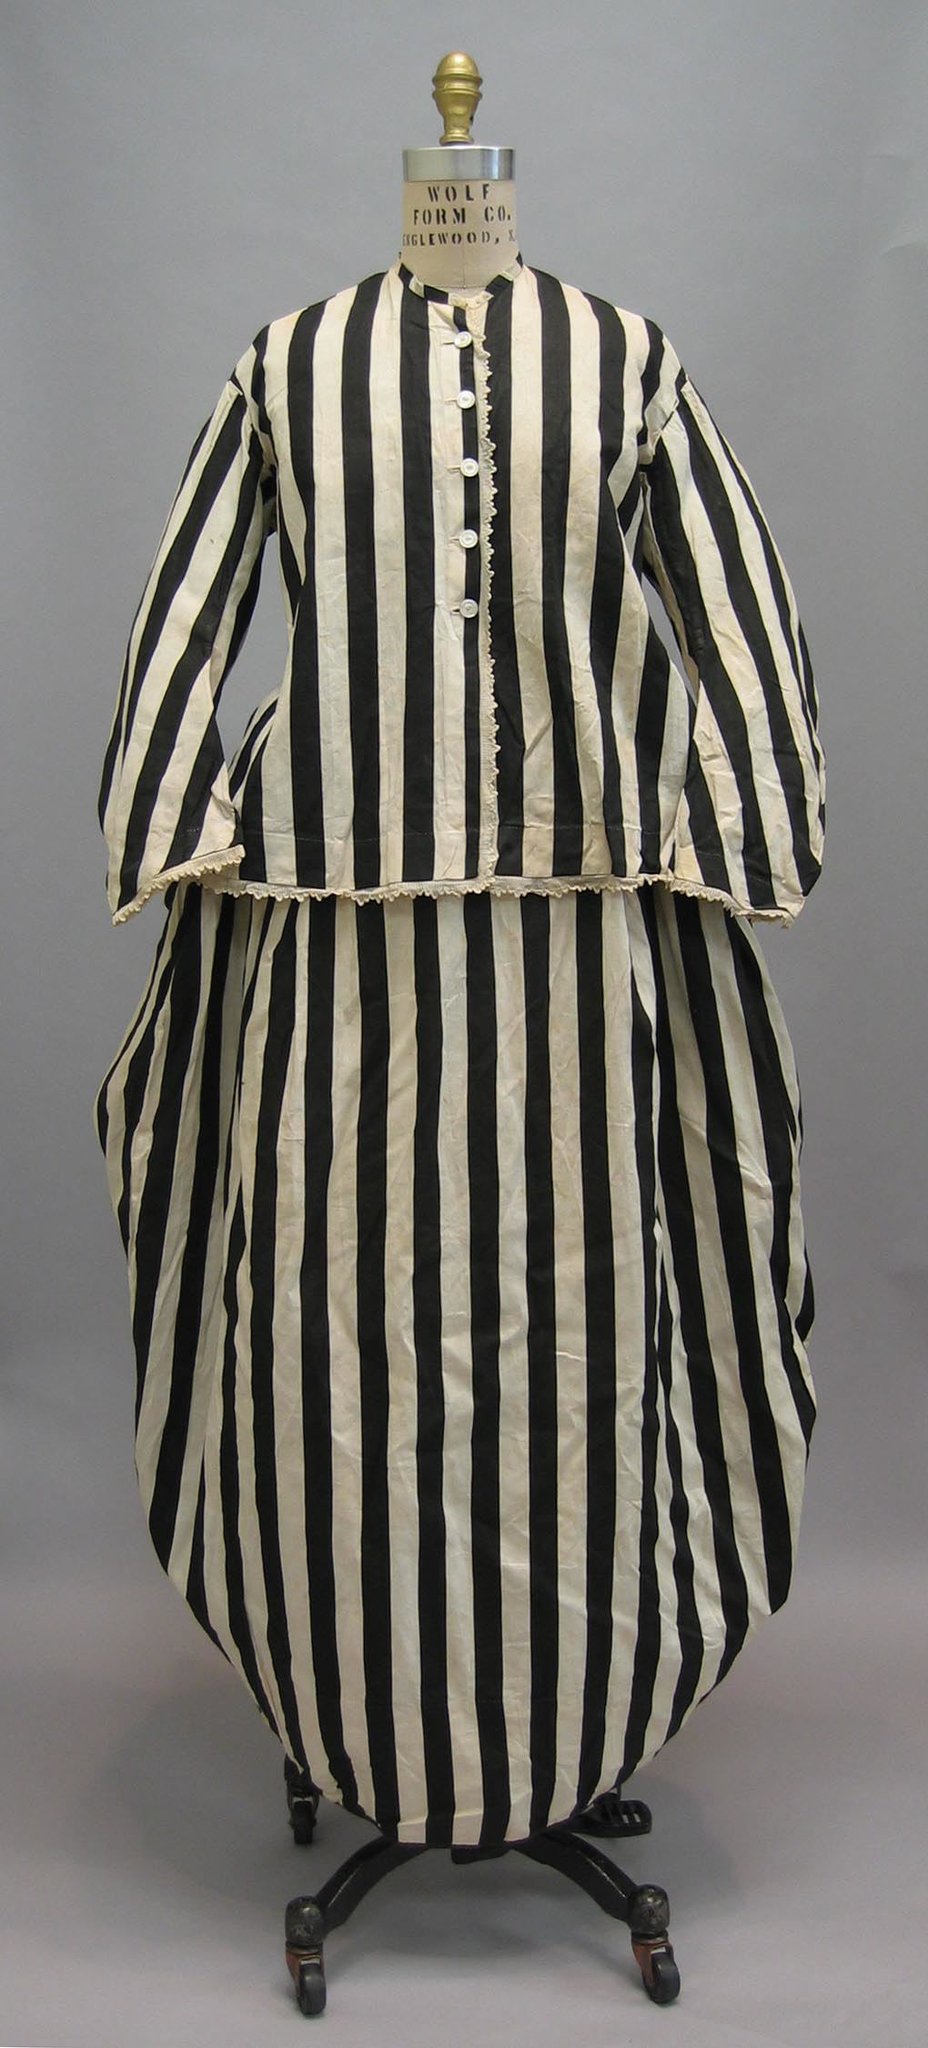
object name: beachwear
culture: french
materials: cotton